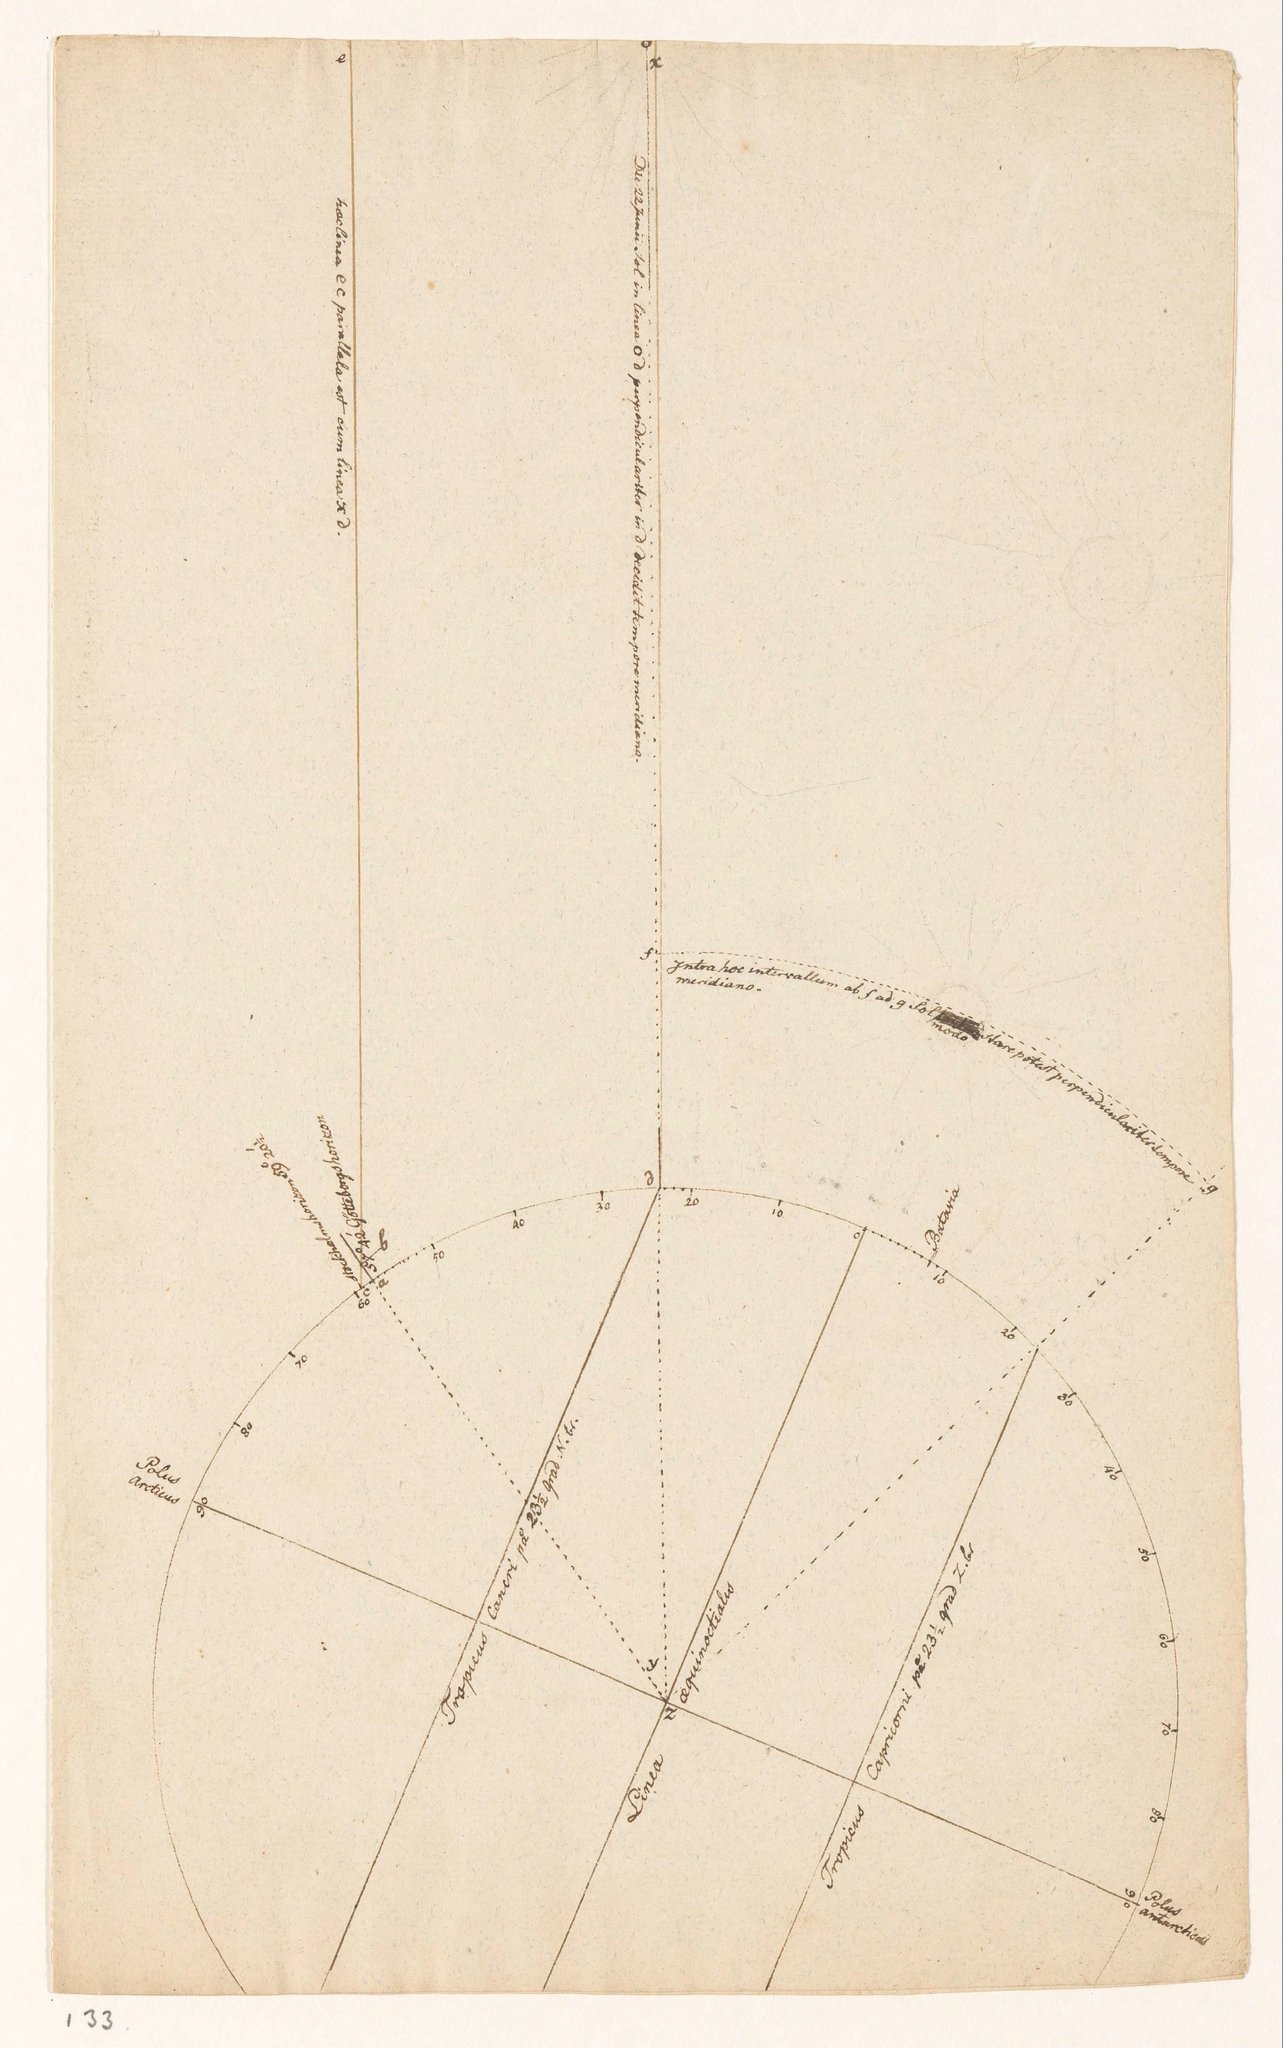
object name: drawing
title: Astronomische studie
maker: jan brandes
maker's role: draughtsman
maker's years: 1743-1808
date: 1702-1792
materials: ink, paper, pencil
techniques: pen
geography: skälsebo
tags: astronomy (and cosmography)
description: Diagram en aantekeningen over hoe de zon staat ten opzichte van de evenaar en de keerkringen en bepaalde andere punten op aarde waarvan Batavia en Stockholm zijn aangegeven. Dubbelgevouwen blad met opschrift.